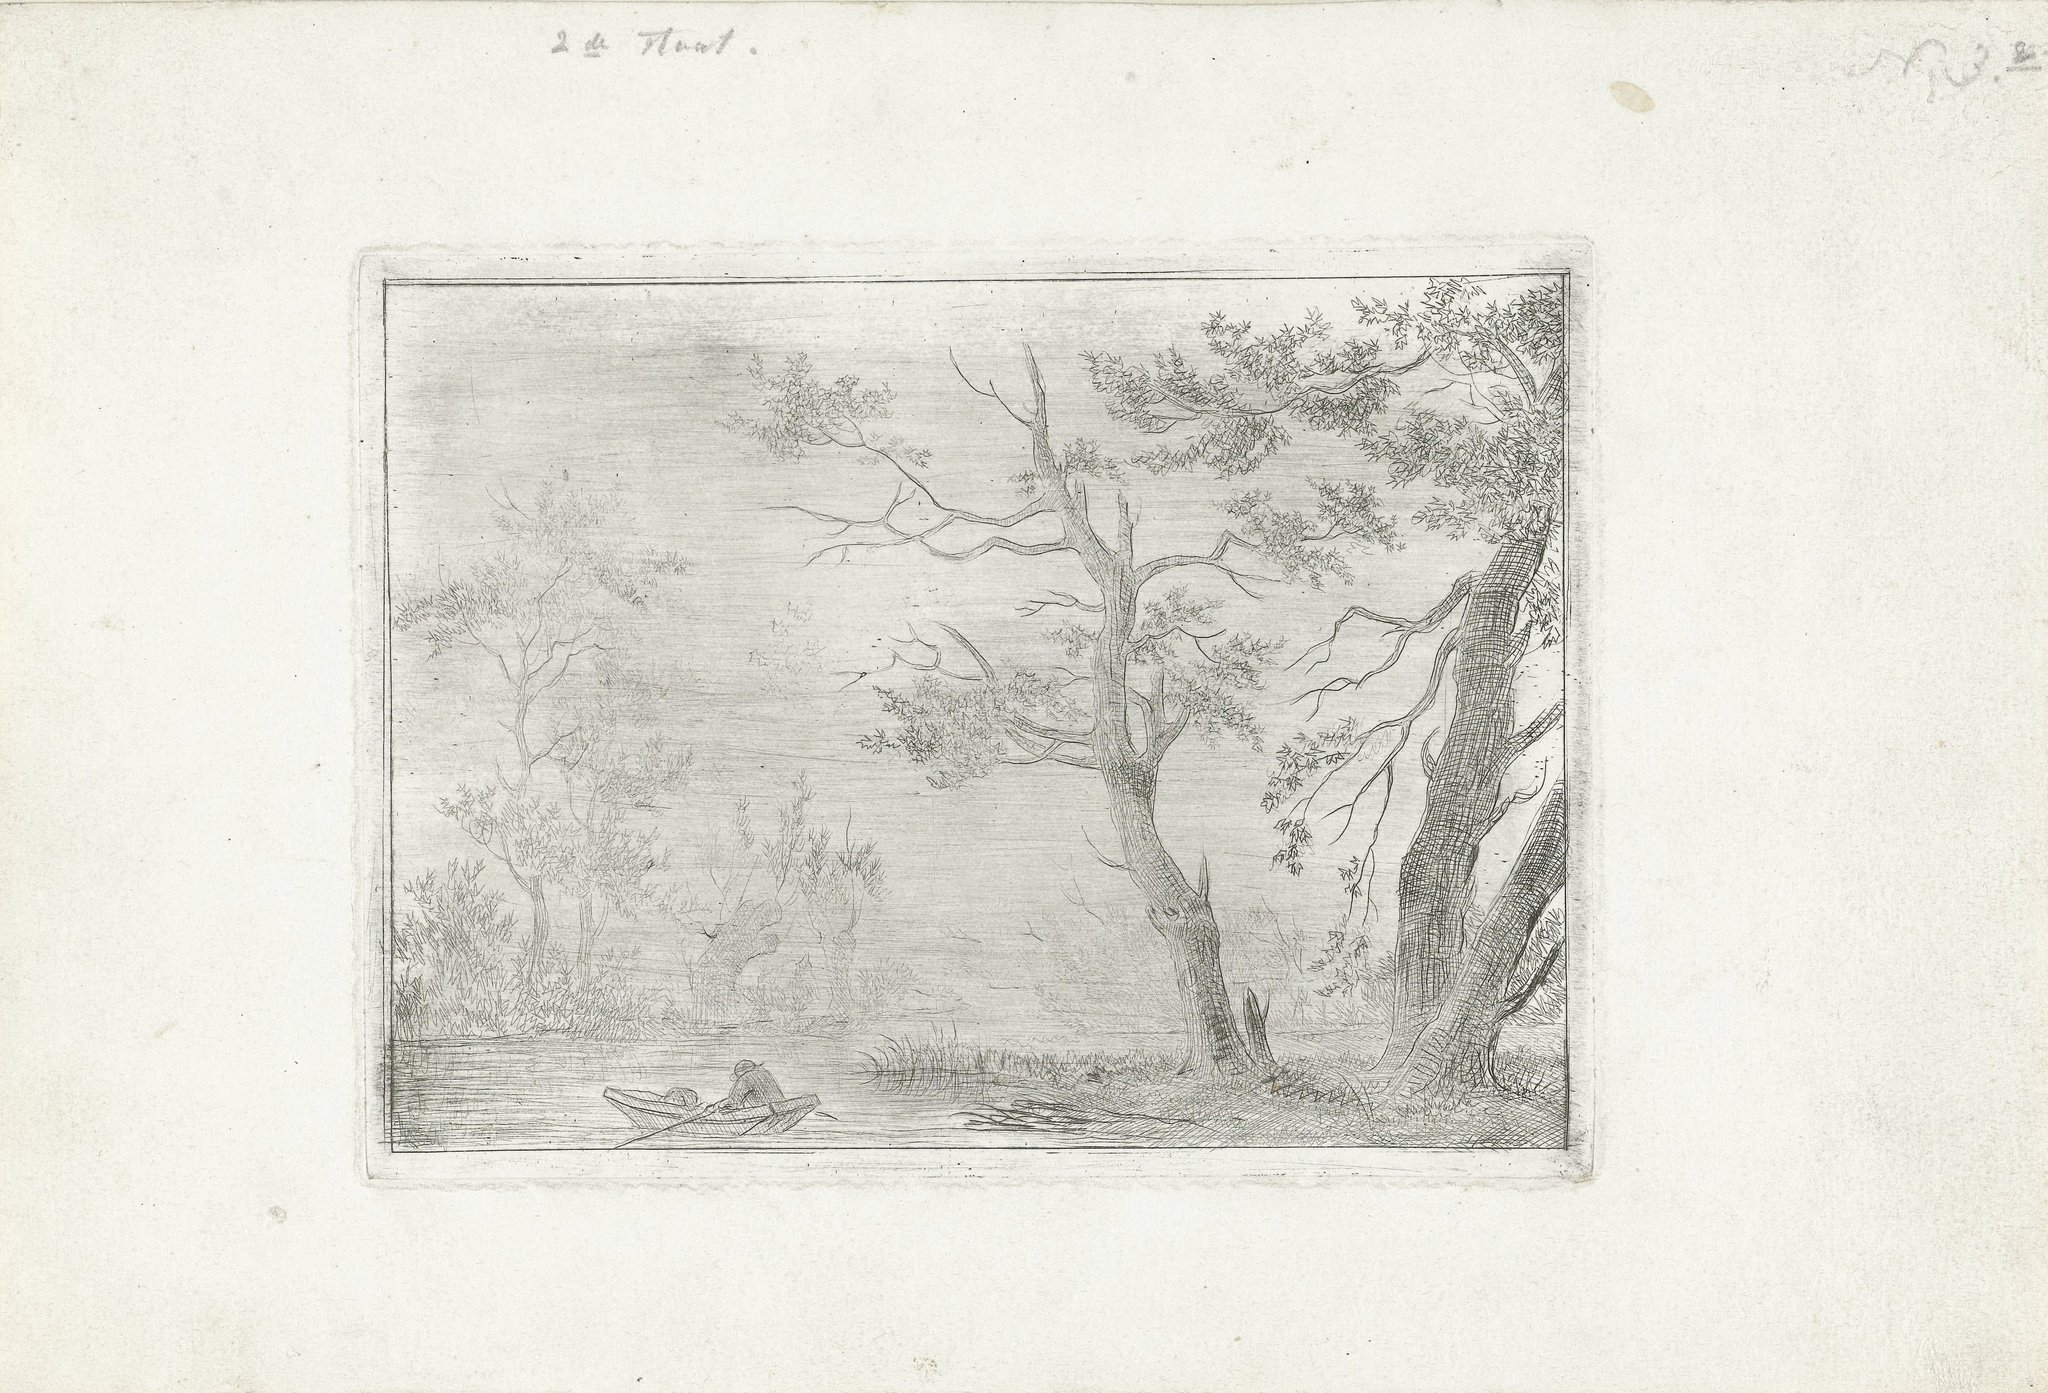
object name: print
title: Nachtgezicht met een figuur in een boot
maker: cornelis van der griendt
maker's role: draughtsman, painter, print maker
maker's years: 1827-1918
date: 1850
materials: paper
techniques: etching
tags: rowing-boat, canoe, etc., windmill, landscapes with waters, waterscapes, seascapes (in the temperate zone) - hh - ideal landscapes (+ landscape with figures, staffage)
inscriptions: collector's mark: Lugt 2228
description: Nachtgezicht met een figuur in een roeiboot omgeven door water en bomen. Op de achtergrond een kerktoren en twee molens.